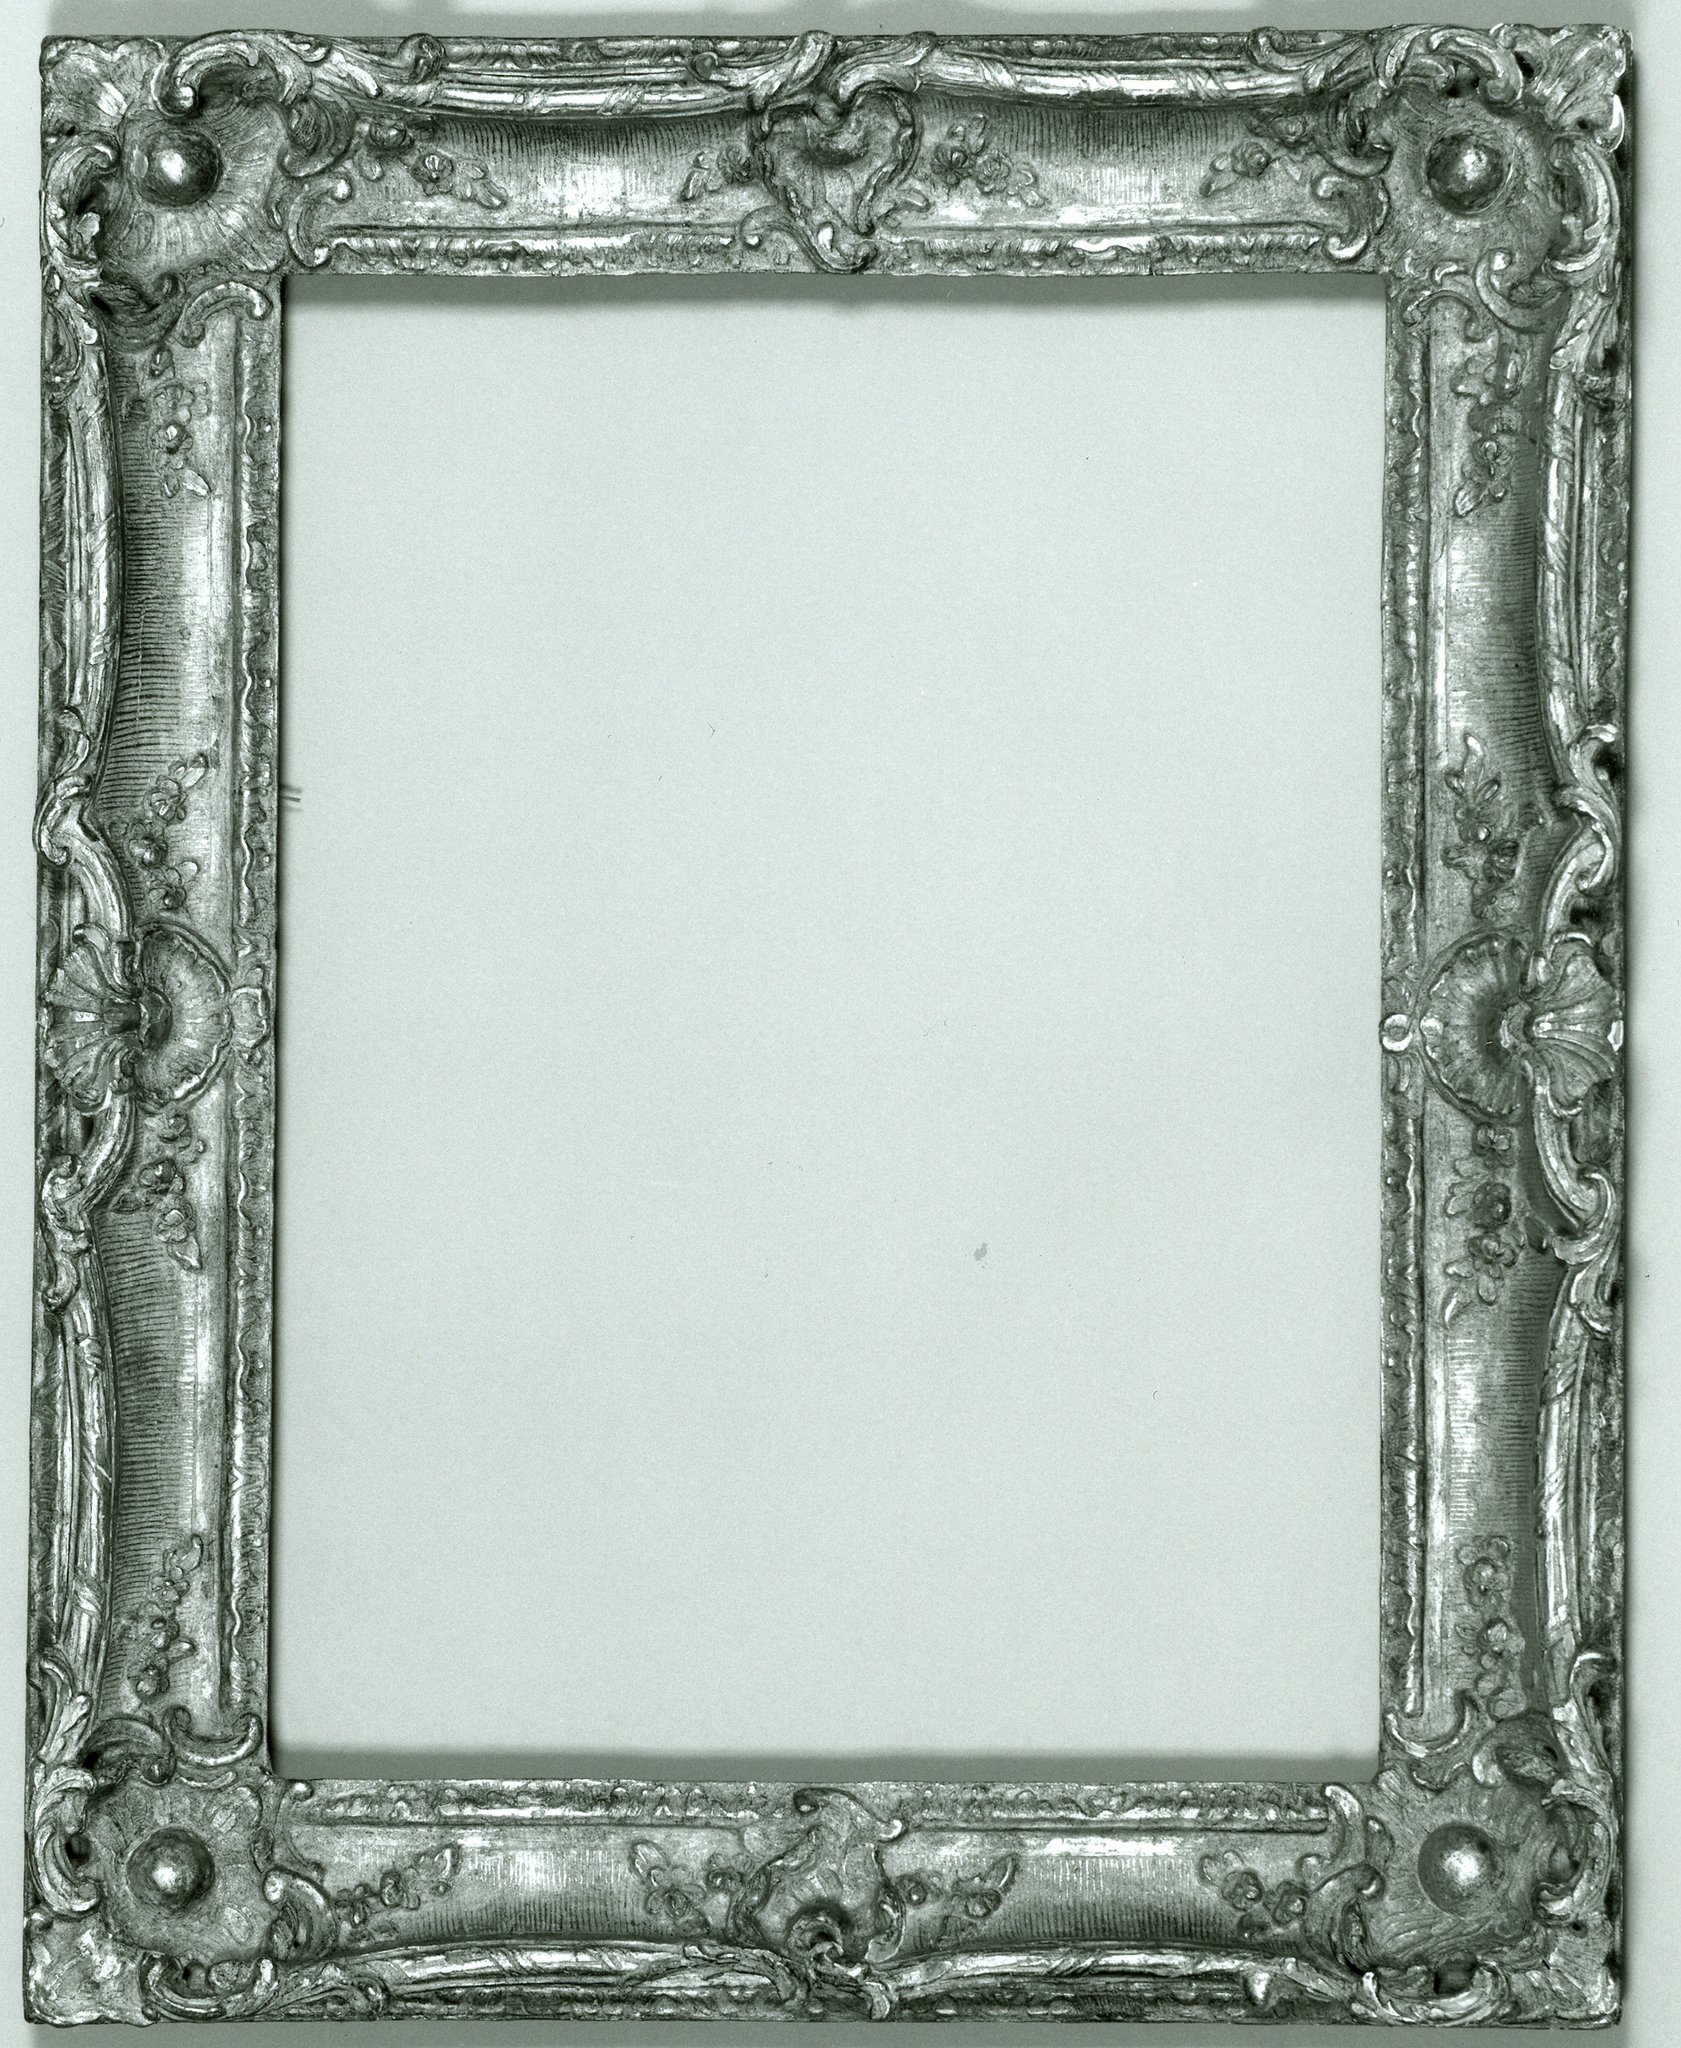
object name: frame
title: 19th century copy of Louis XV style frame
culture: french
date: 1801-1900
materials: wood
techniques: carving, gilding